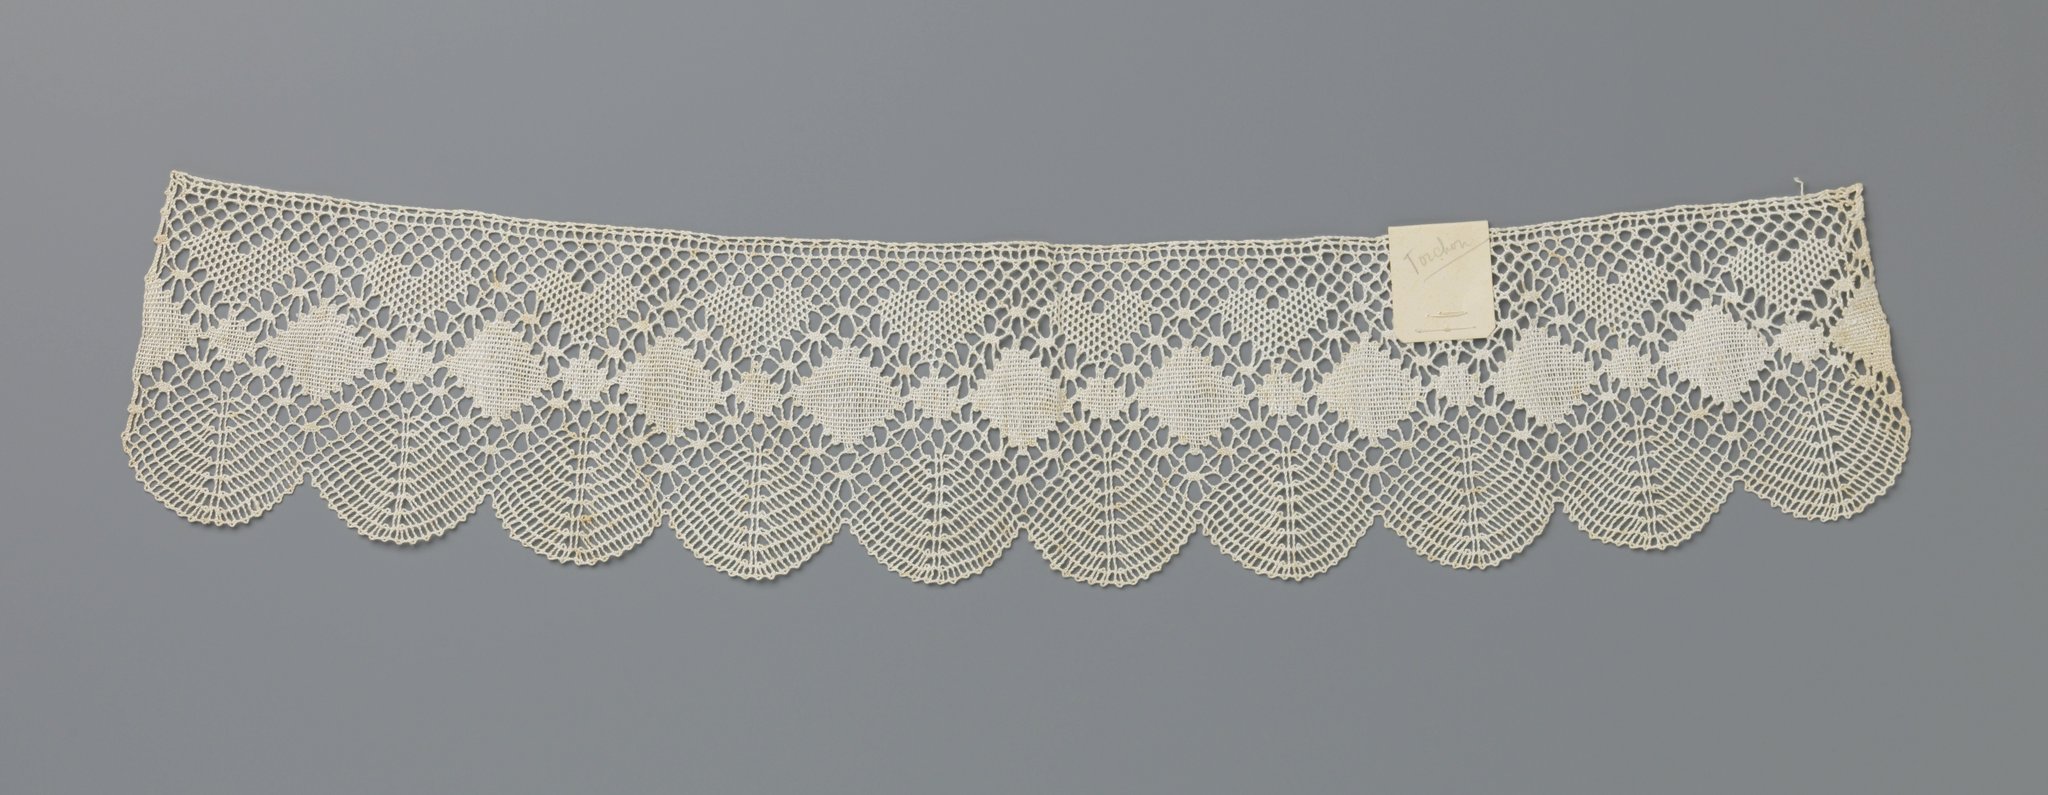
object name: strip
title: Strook kloskant met waaiers en ruiten en harten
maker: Anonymous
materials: linen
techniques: lace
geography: fort de kock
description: Strook naturelkleurige kloskant: stropkant. Het zich herhalende patroon bestaat uit een schulpenrand van waaiers waarboven een rij grote ruiten wordt afgewisseld met kleinere en daarboven een rij harten. Om de ruiten heen lopen zigzag-banen met spinnen. De ruiten zijn gemaakt in linnenslag, de harten in netslag. Aan de bovenkant van de strook zijn de harten met elkaar verbonden door een stroptraliegrond. Aan de strook is een etiket genaaid waarop de handgeschreven tekst: 'Kantwerkcursus Fort de Kock 15/2-15/6-1917 Lian Fort v/d Capellen Kant no. 4'.